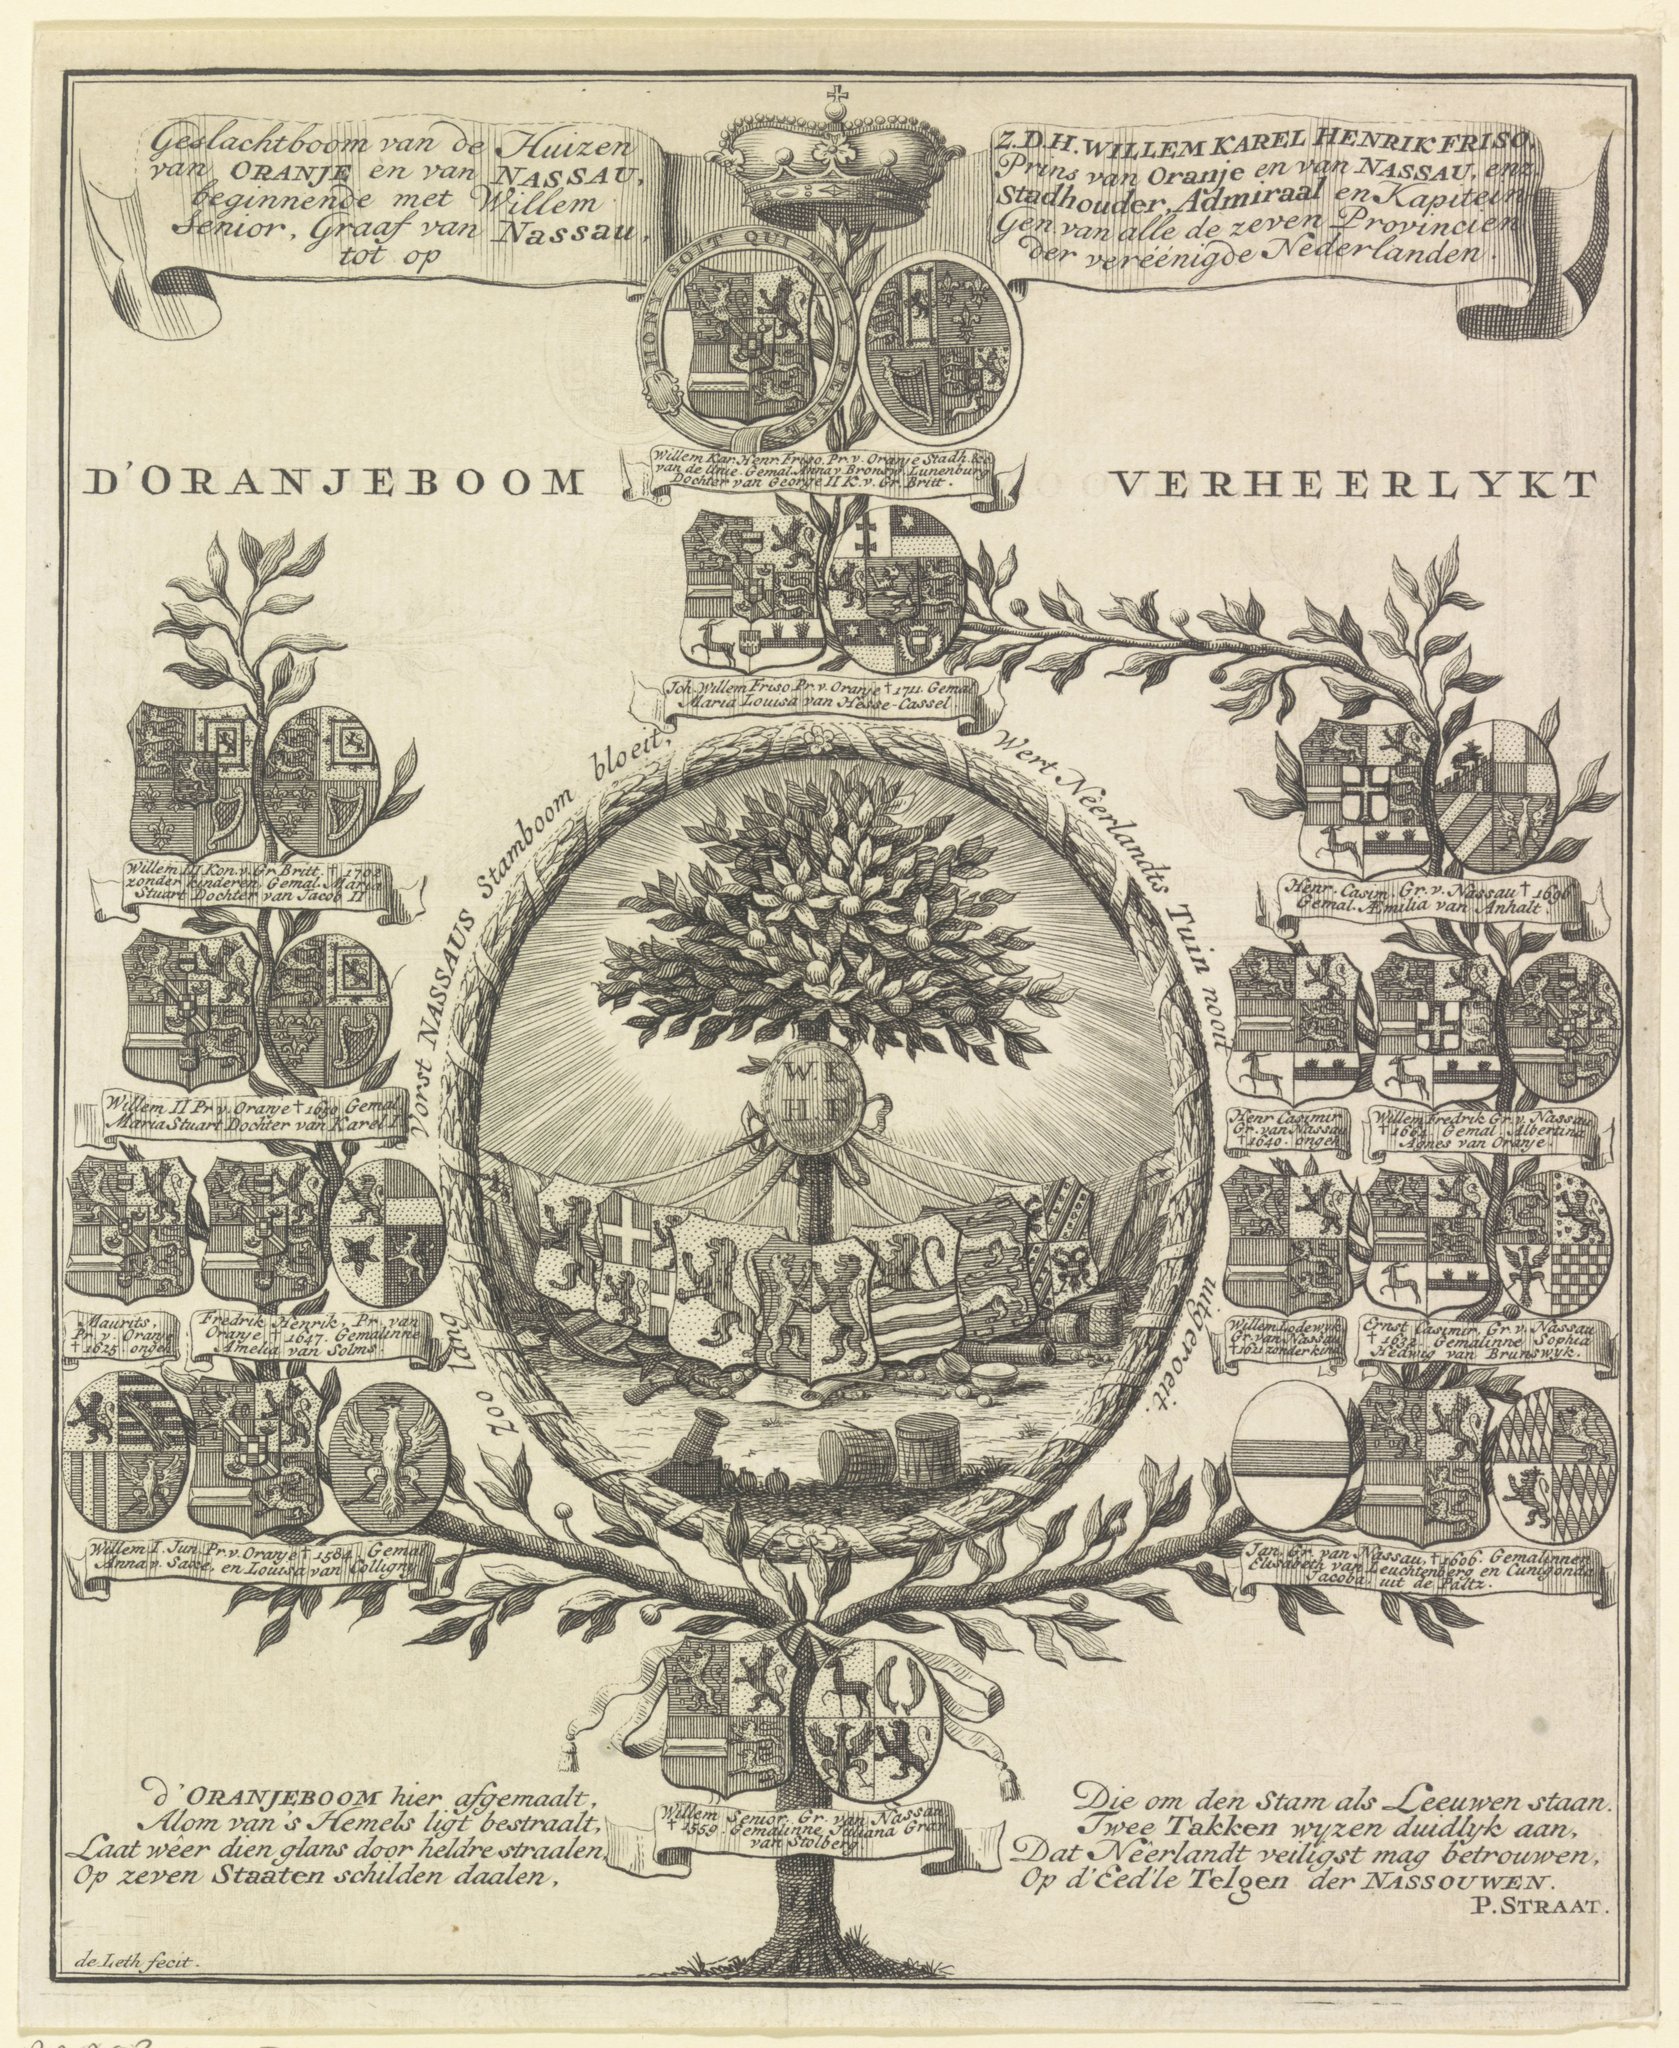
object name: print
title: d'Oranjeboom verheerlykt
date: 1747-1766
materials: paper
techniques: engraving, etching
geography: amsterdam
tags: louise de coligny, william iii (prince of orange and king of england, scotland, and ireland), frederick henry (prince of orange), william ii (prince of orange), delft, william i (prince of orange), maurice (prince of orange), maria ii stuart (koningin van engeland, schotland en ierland), amalia of solms-braunfels, london, mary henrietta stuart, willem iv (prins van oranje-nassau), the hague, anna van hannover, knighthood order (garter) - insignia of a knighthood order, e.g.: badge, chain, family lineage, pedigree, genealogical tree or table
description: Stamboom van het Huis Oranje-Nassau, van Willem I tot en met Willem IV. In het midden de Oranjeboom in een ovaal met randschrift. Aan de stam een plakkaat met de initialen van Willem IV en een aantal wapens. Daar omheen aan de takken van een boom meerdere wapens met in cartouches namen en sterfdata. Linksonder en rechtsonder vier regels Nederlandse tekst.